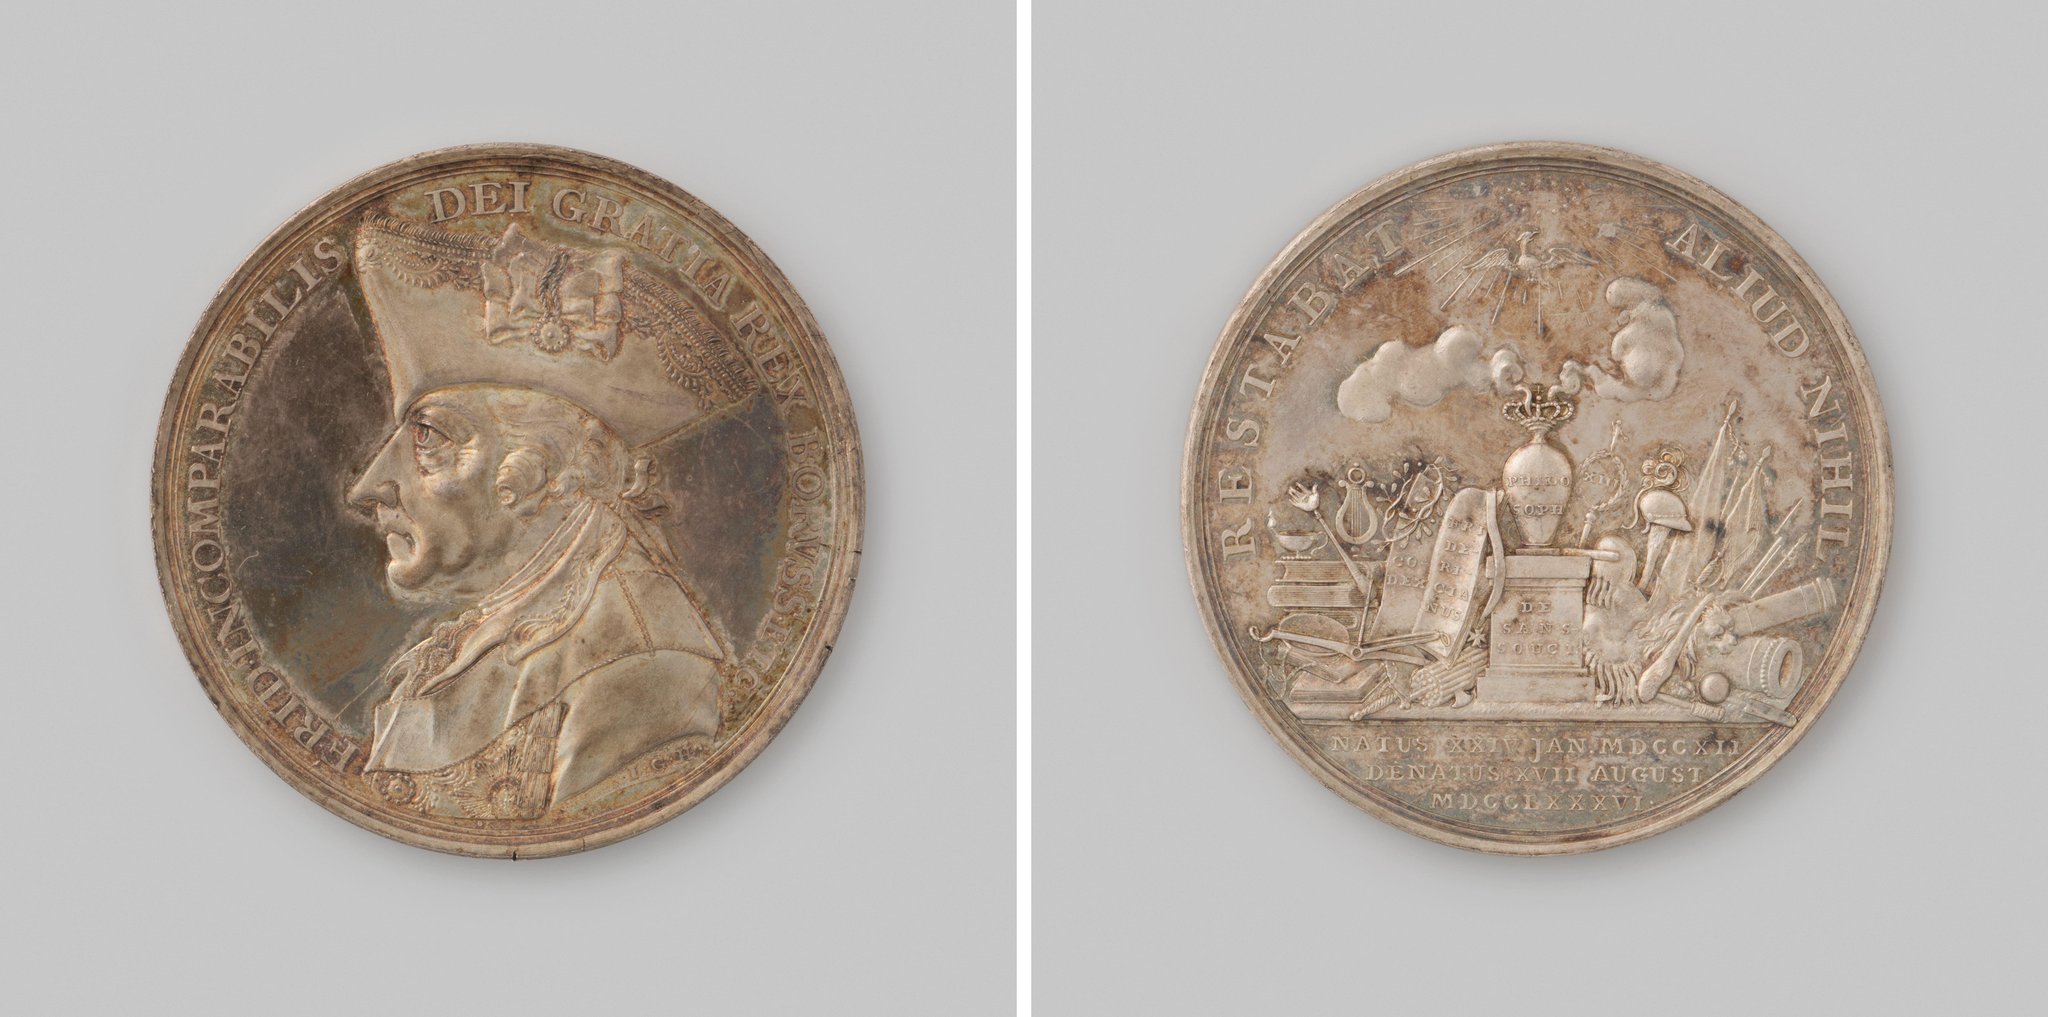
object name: history medal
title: Overlijden van Frederik Willem II van Pruisen 1786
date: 1786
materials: silver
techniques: pressing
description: Zilveren penning, op de voorzijde het borstbeeld van Frederik Willem met driepuntige steek naar links met omschrift, op de keerzijde te midden van burgerlijke en militaire attributen een altaar met een gekroonde urn waaruit een adelaar ten hemel stijgt, met omschrift en afsnedetekst.